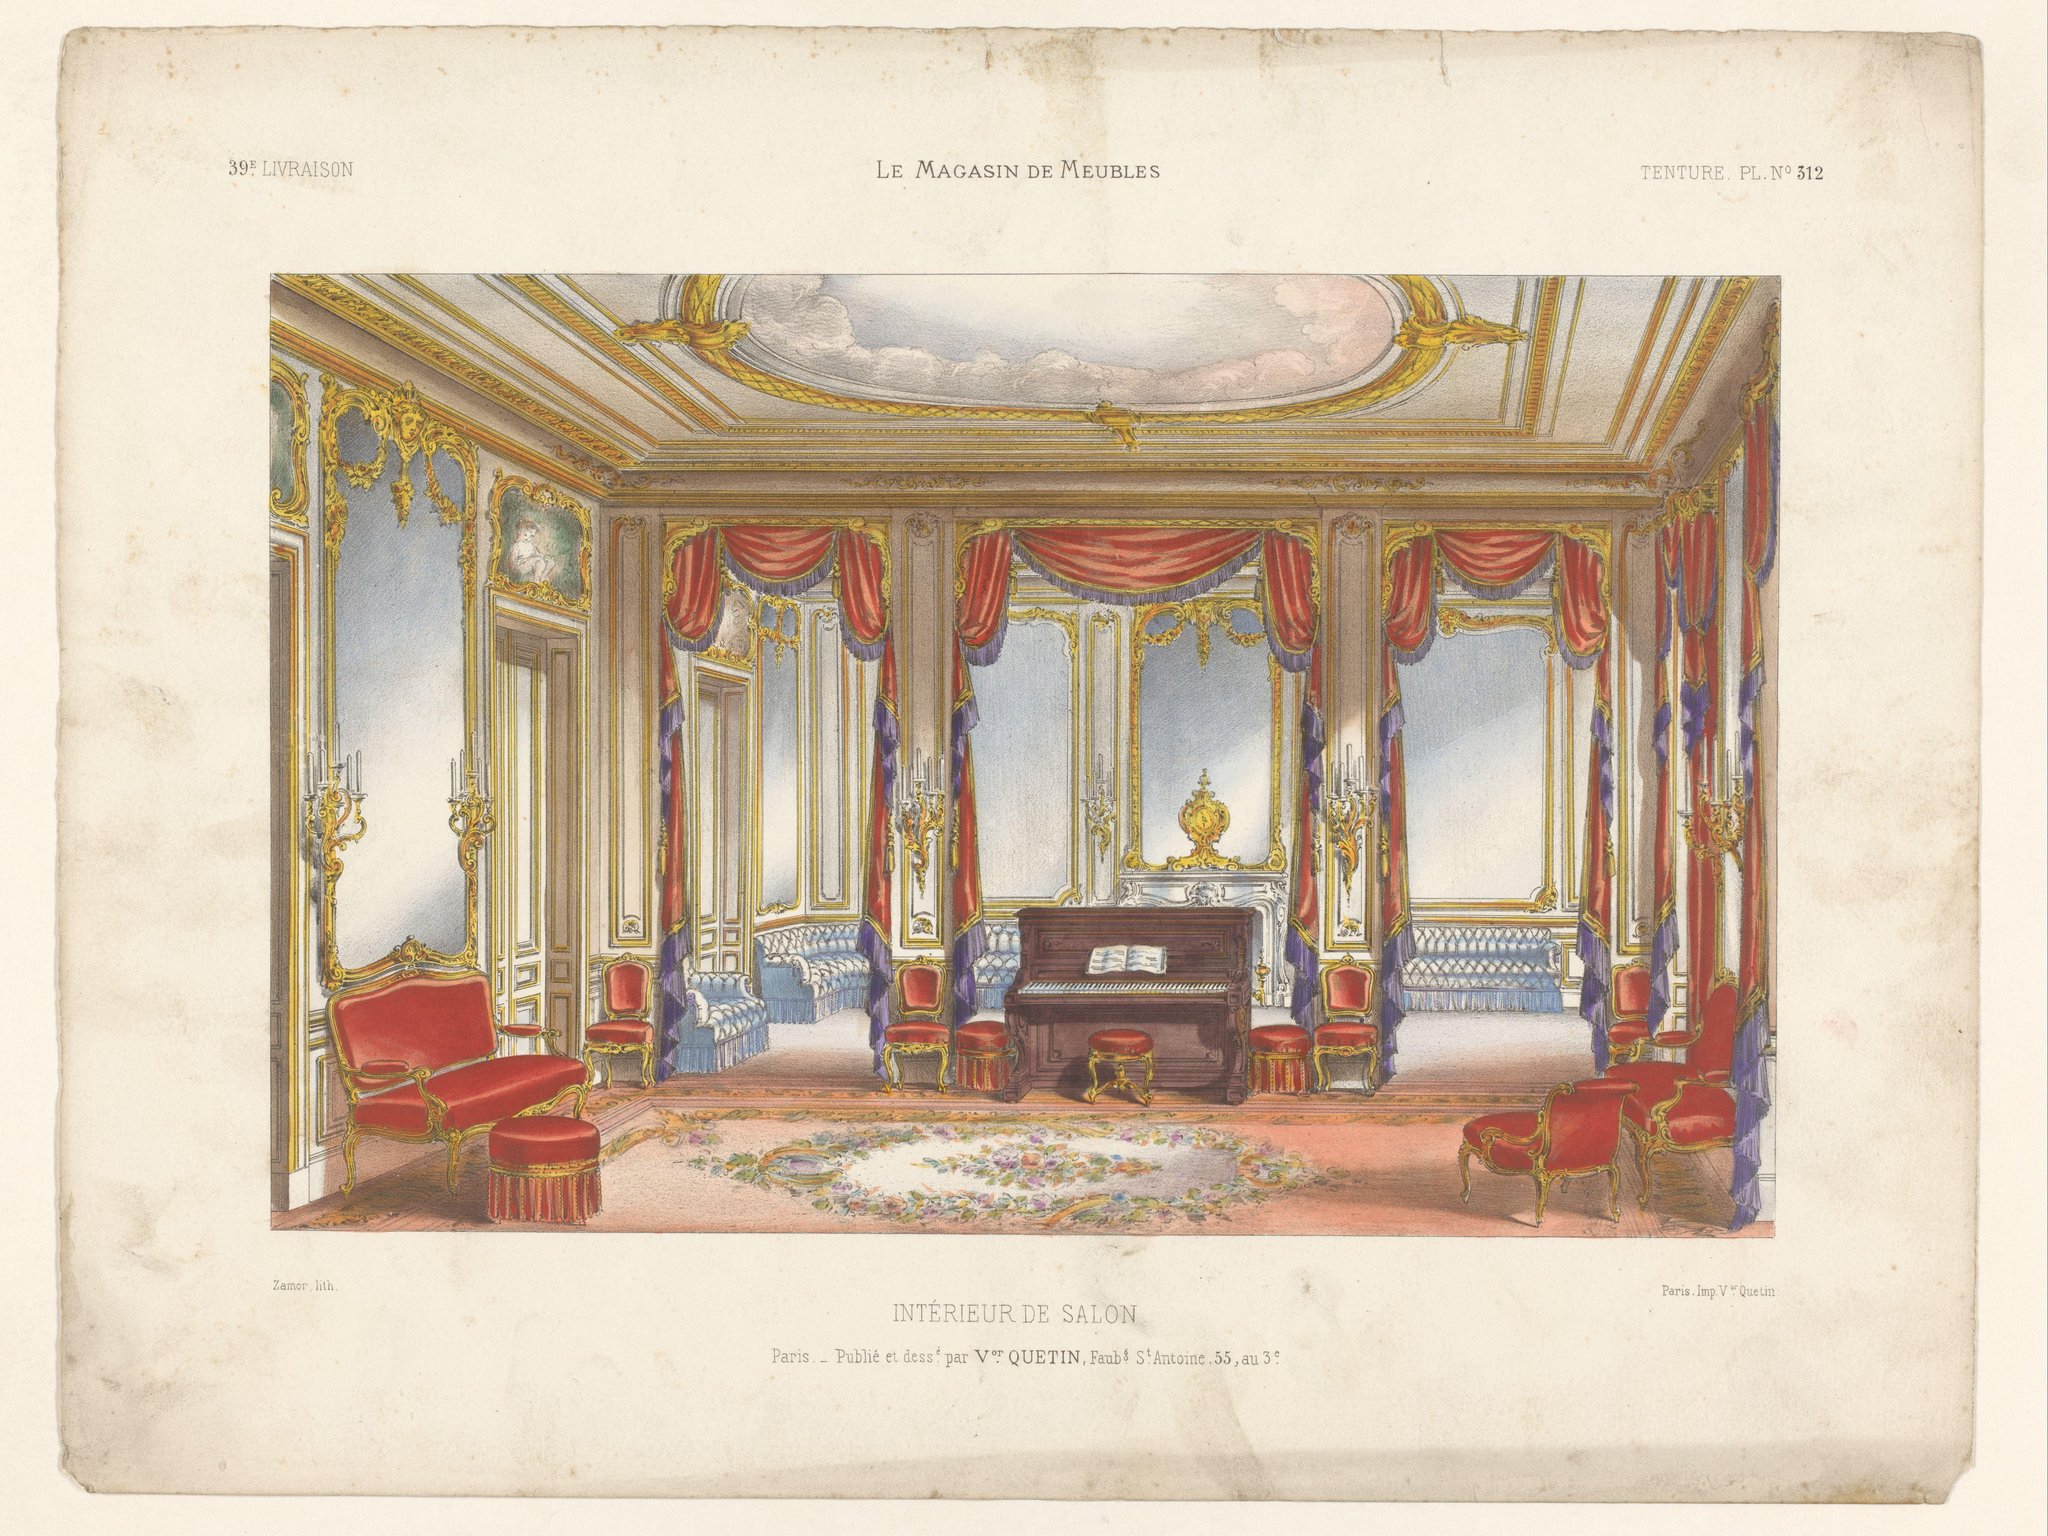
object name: print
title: Interieur met piano en draperieën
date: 1832-1877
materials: paper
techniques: hand coloring, lithograph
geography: paris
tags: interior of the house, hangings and drapery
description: Een interieur met een piano, banken, stoelen, spiegels en draperieën. Prent uit 39e Livraison.